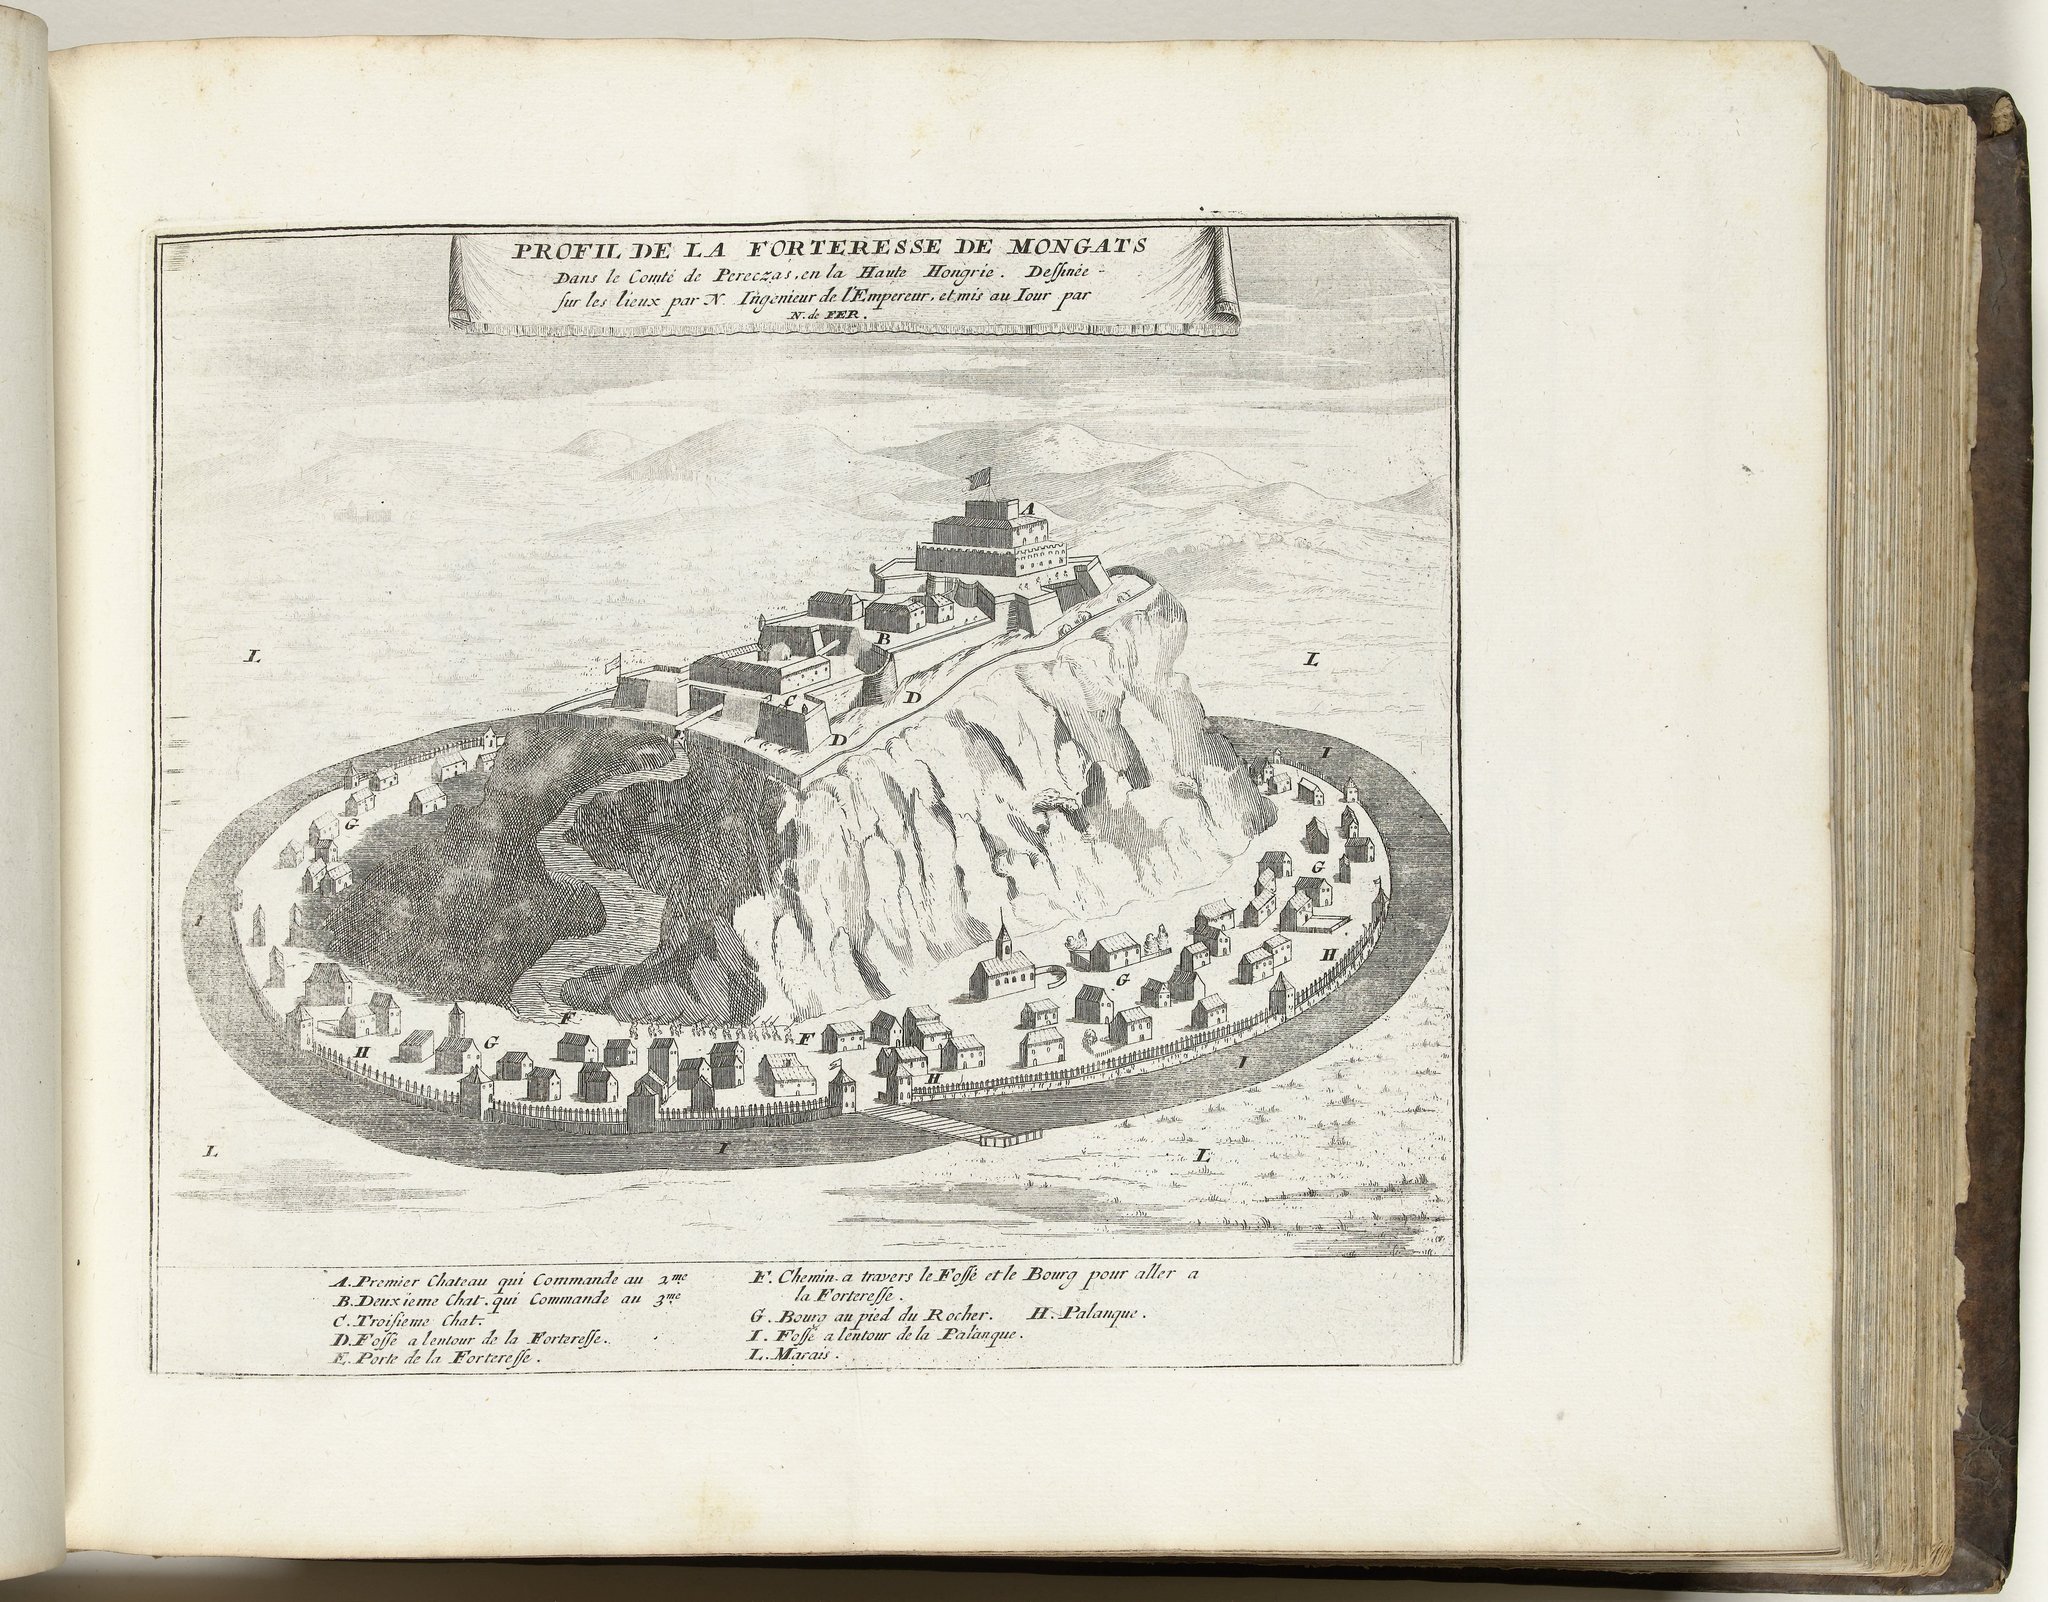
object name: map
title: Les forces de l'Europe, ou description des principales villes, avec leurs fortifications : dessignées par les meilleurs ingenieurs, particulierement celles (...) de la France, dont les plans ont esté levez par M. de Vauban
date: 1693-1695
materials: paper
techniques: etching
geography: paris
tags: maps of separate countries or regions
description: Gezicht op de vesting Munkács of Mongats (Mukachevo) in Boven-Hongarije, het huidige Oekraïne. Onderdeel van het derde deel (1695) van het prentwerk waarin gebundeld zijn de acht delen van Les forces de l'Europe uitgegeven tussen 1693-1697. Het prentwerk bestaat uit 175 platen met plannen (afkomstig van Sébastien Le Prestre, Seigneur de Vauban) van vermaarde sterke steden en vestingen in de Negenjarige Oorlog. Titel en opschriften in het Frans.